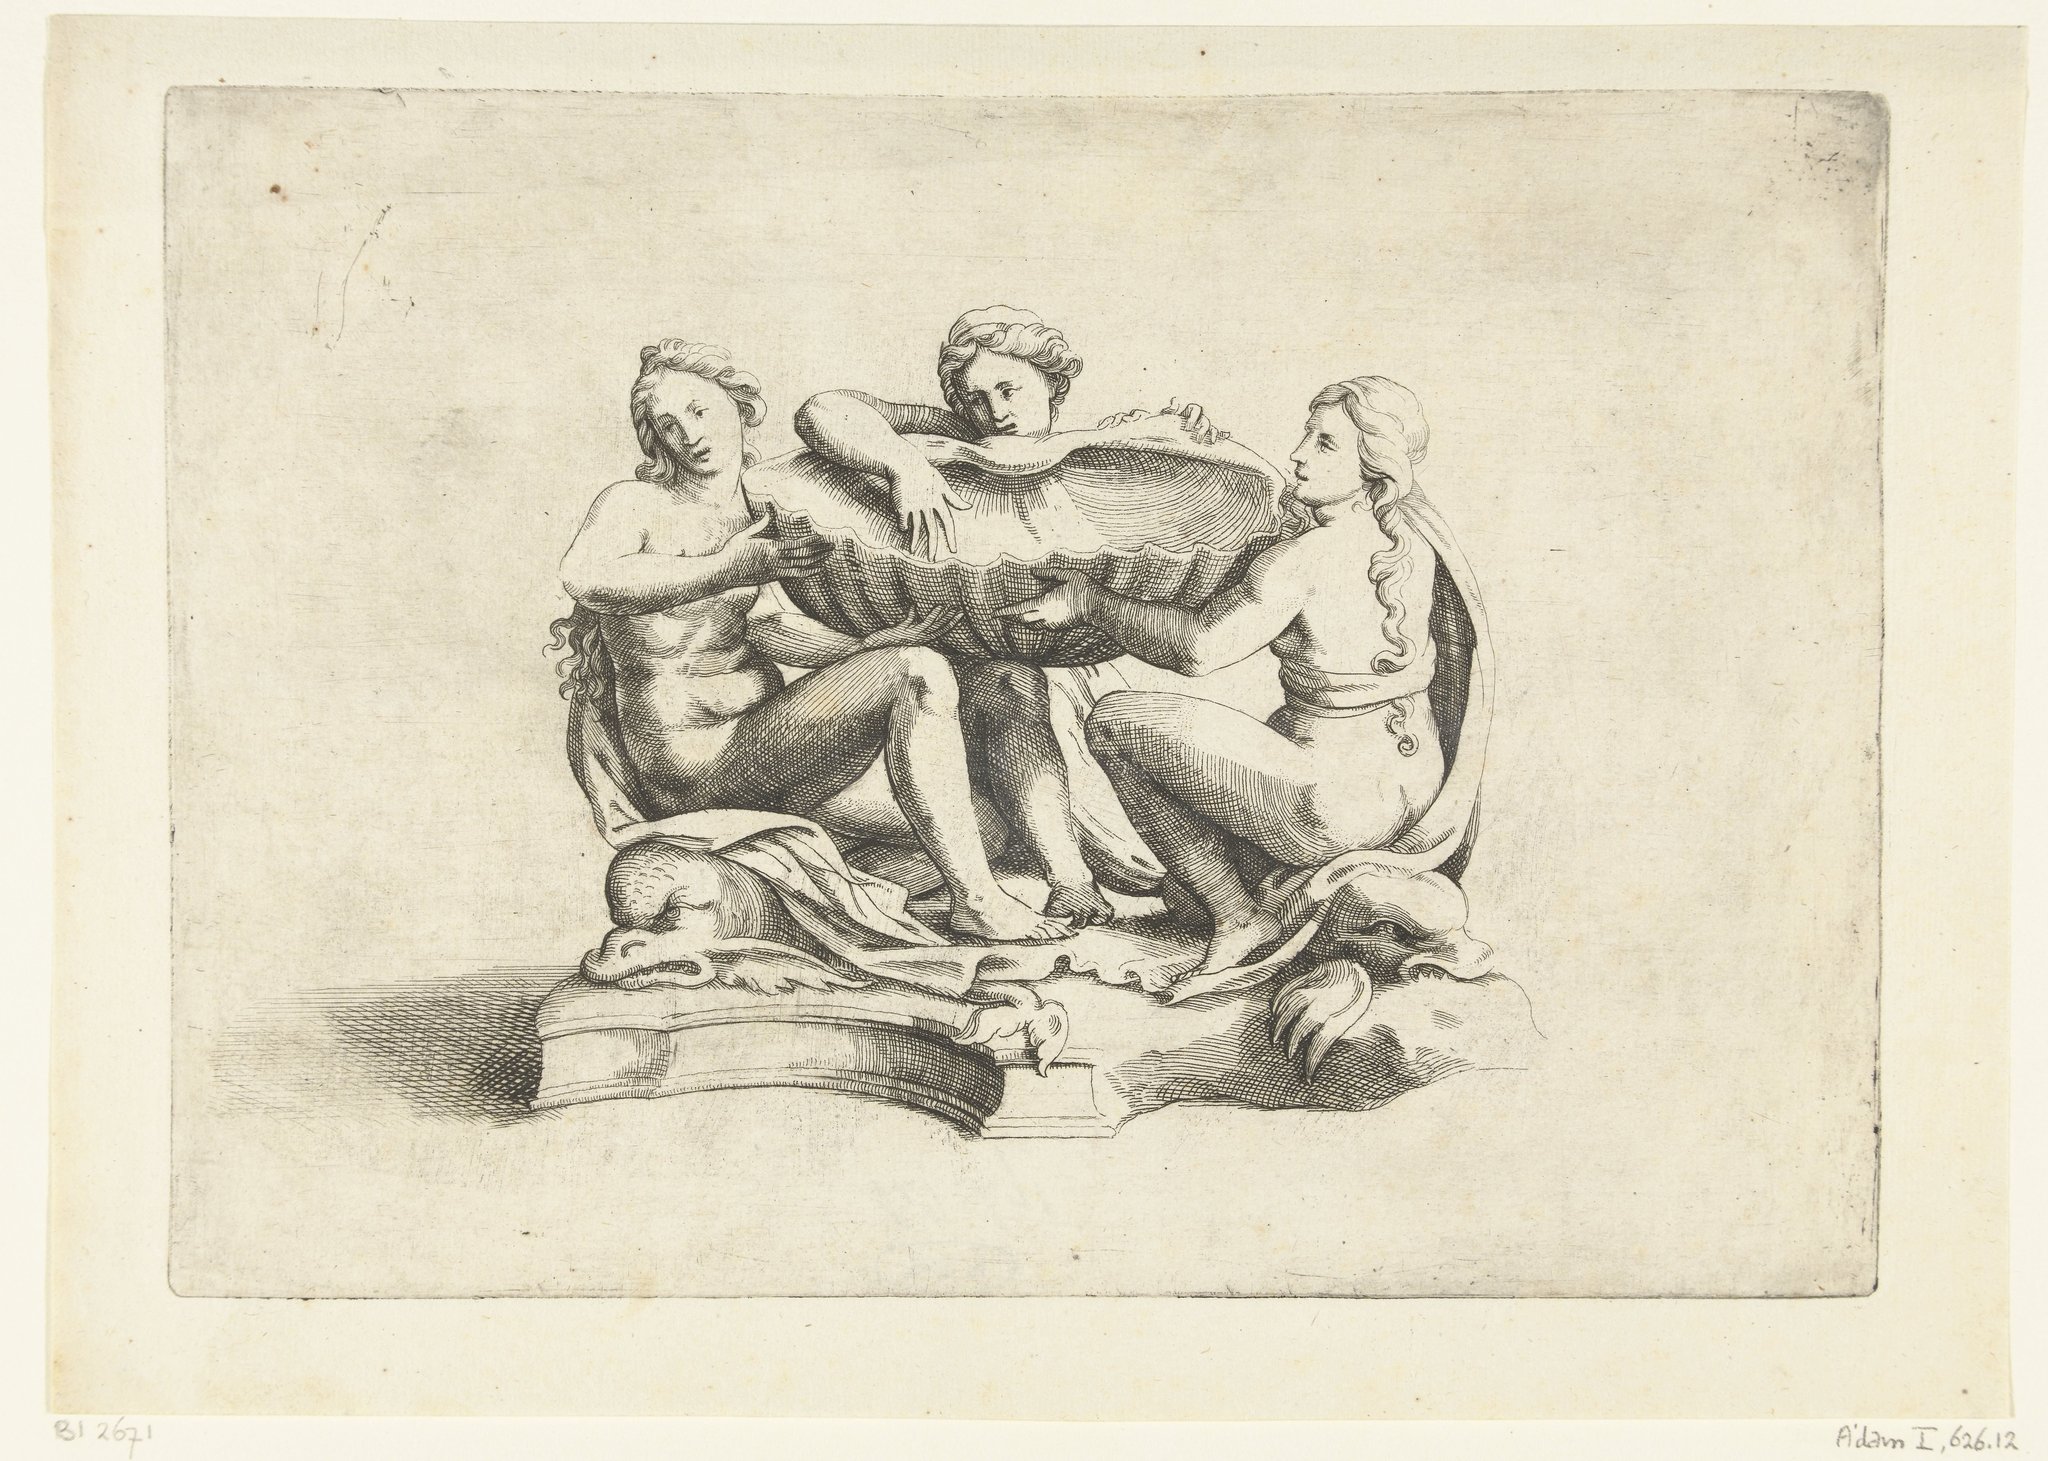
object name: ornament print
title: Schelpvormige schaal, gedragen door drie vrouwen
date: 1614-1654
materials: paper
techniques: etching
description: Uit serie van 14 bladen met schalen, kommen en kistjes.